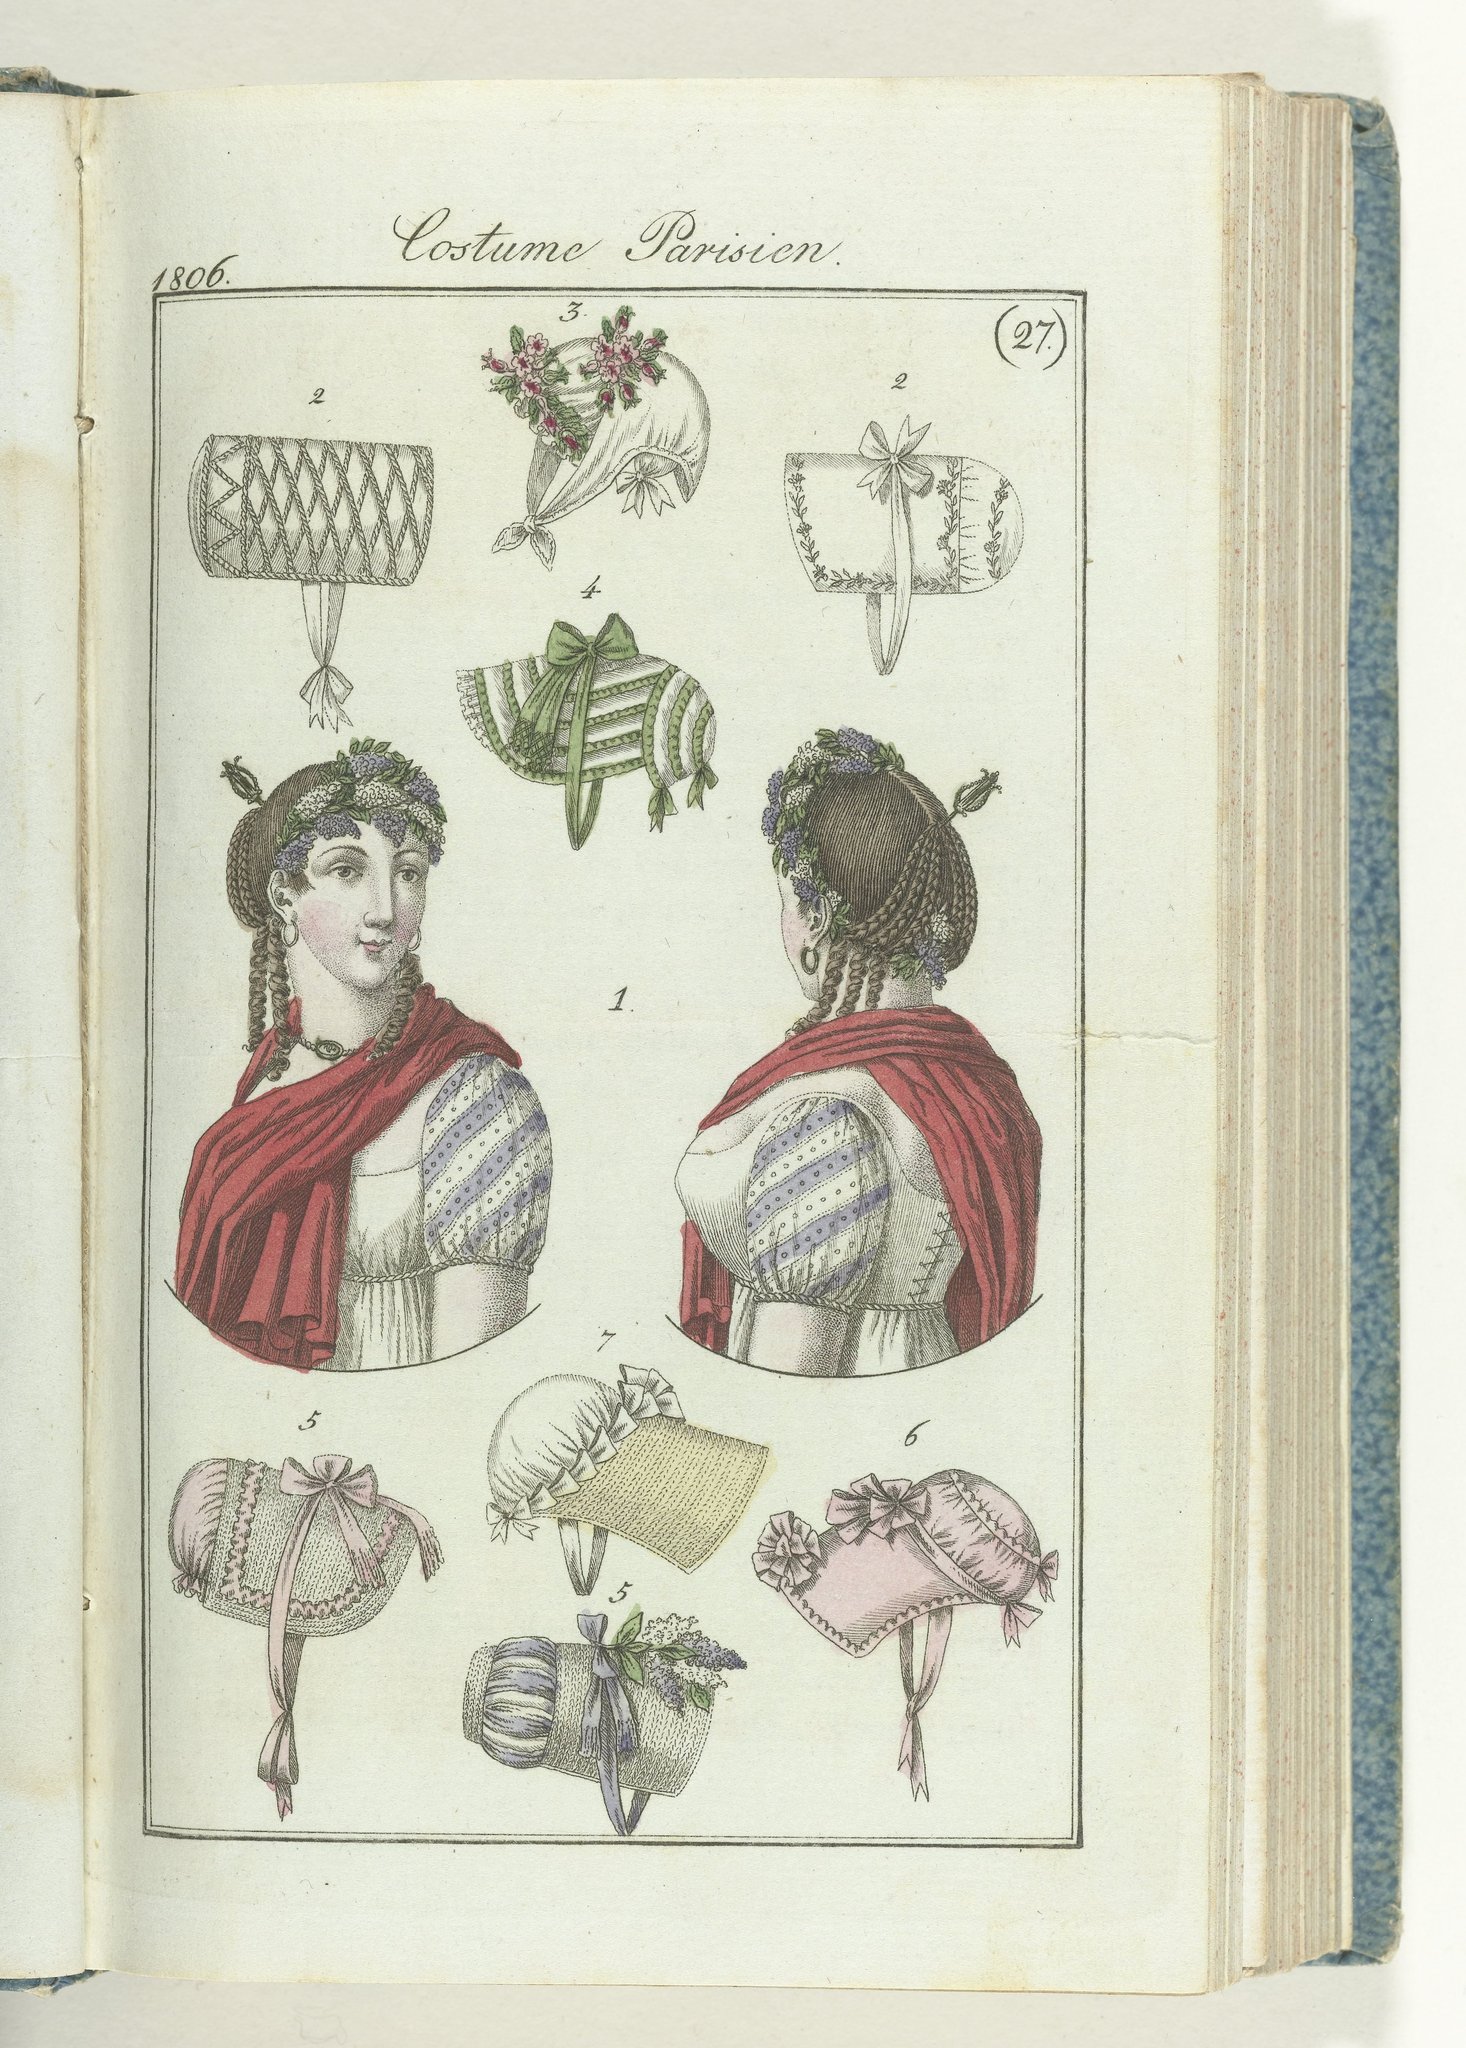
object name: fashion print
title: Journal des dames et des modes, editie Frankfurt 1 juillet 1806, Costume Parisien (27)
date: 1806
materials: paper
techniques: engraving, hand coloring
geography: frankfurt am main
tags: head-gear (capote) (+ women's clothes), styles of hairdress (with name) - aa - ~ women, styles of hairdress - aa - ~ women, head-gear: cap (+ women's clothes), head-gear (bonnet) (+ women's clothes), fashion plates, head-gear: hat (+ women's clothes)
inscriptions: title: ‘Costume Parisien.’